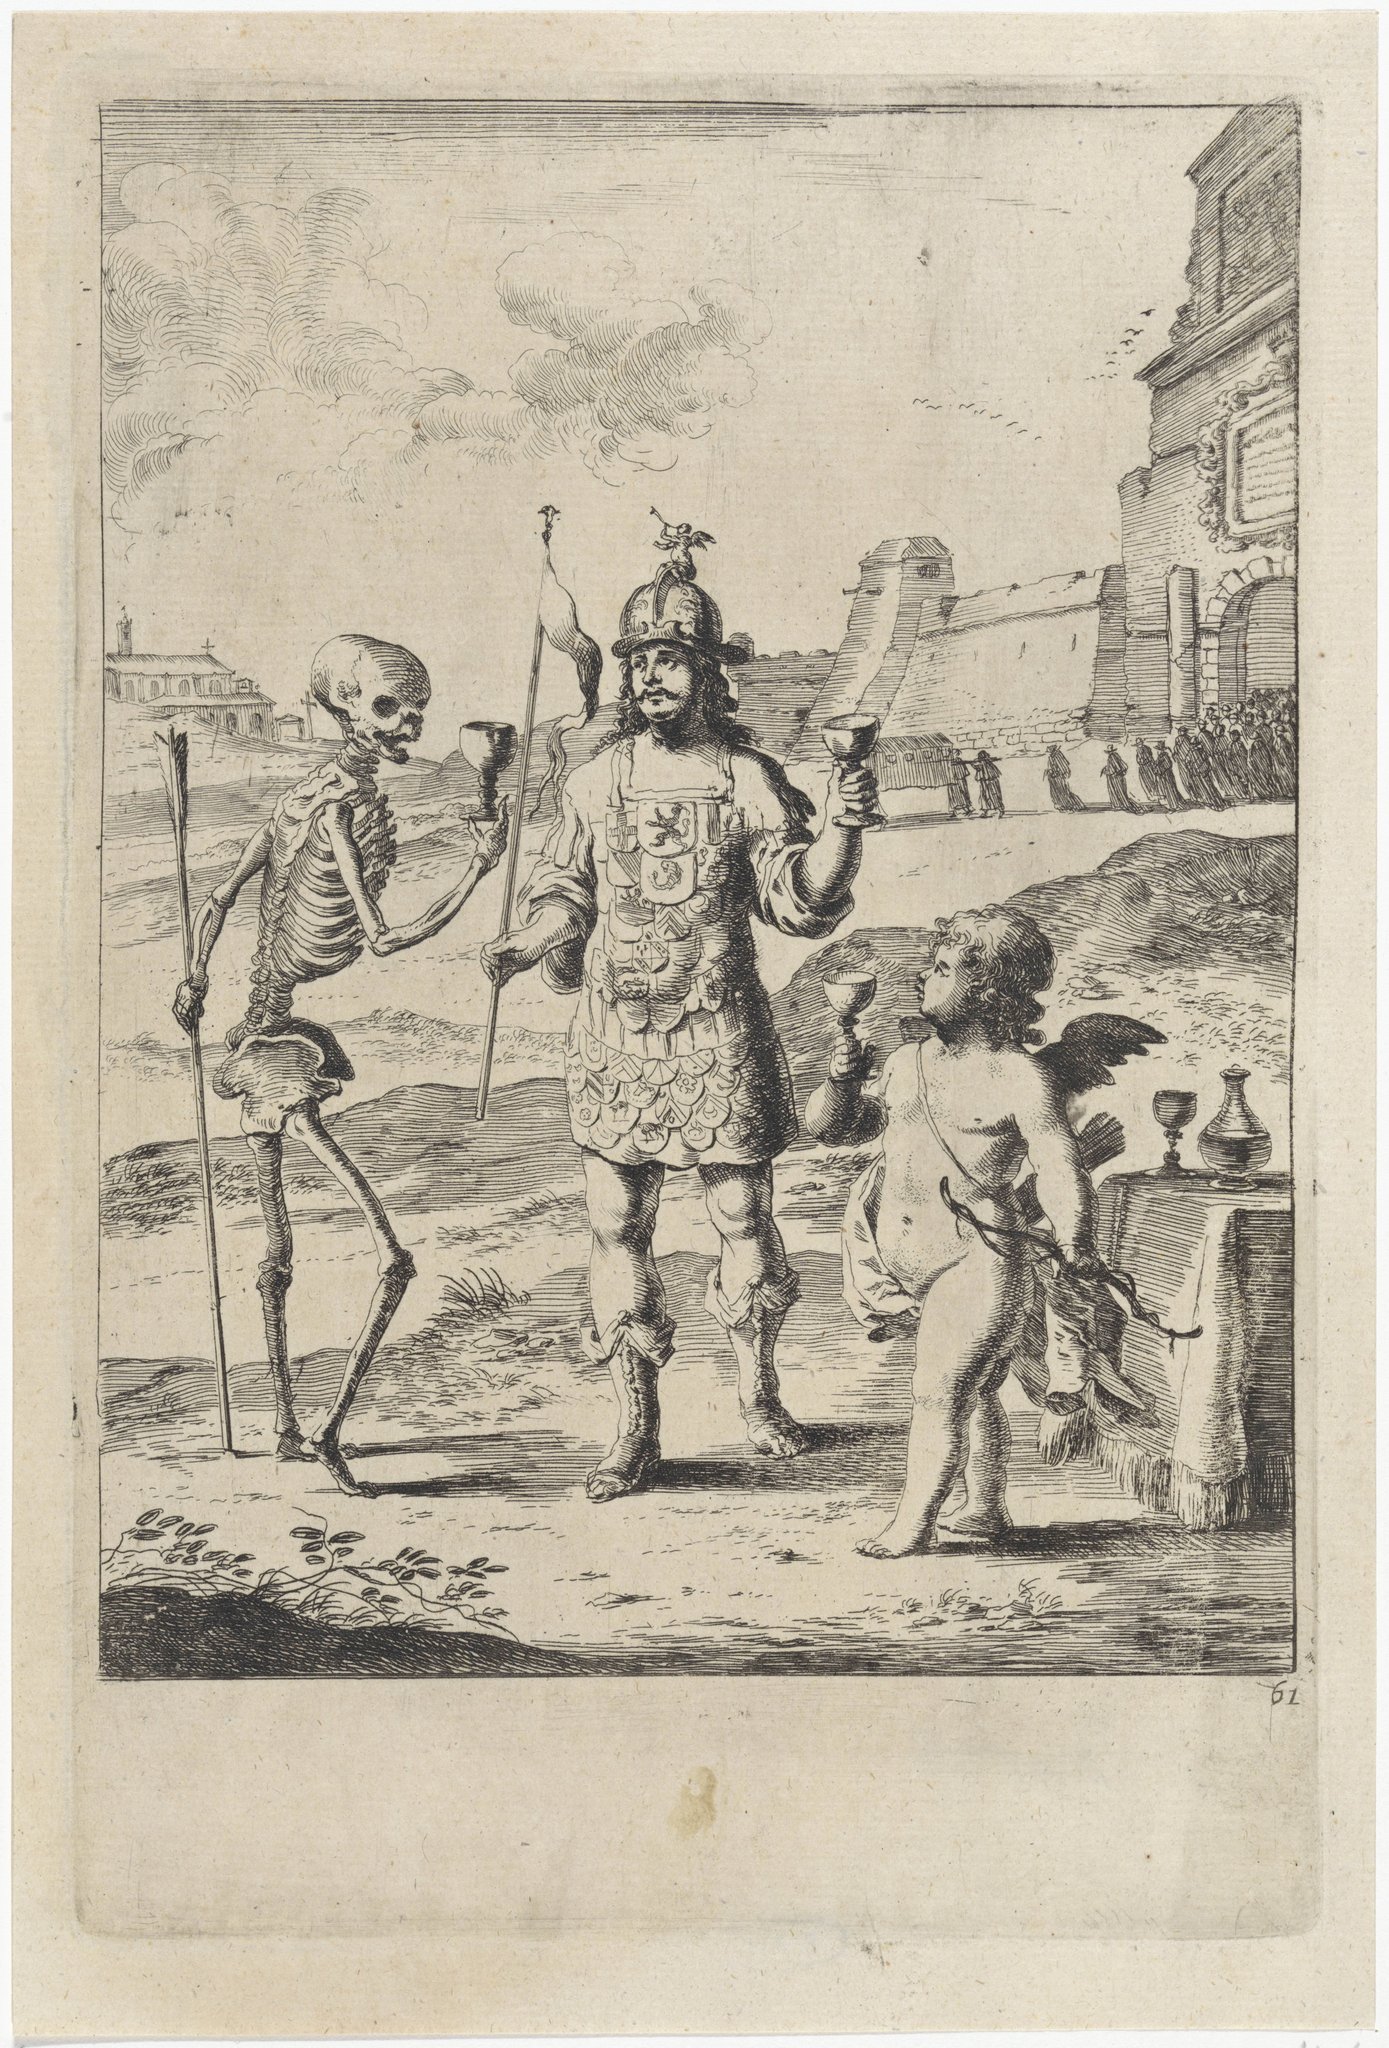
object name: book illustration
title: Fabels van Aesopus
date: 1665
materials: paper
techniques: etching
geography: london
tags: repute, renown; 'splendore del nome' (ripa) (+ personification), death as skeleton, (story of) cupid, amor (eros), fables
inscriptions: collector's mark: Lugt 2228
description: Prent gebruikt in: Ogilby, John. The Fables of Aesop Paraphras'd in Verse: Adorn'd with Sculpture and Illustrated with Annotations. Londen: John Ogilby, 1665 en 1668.